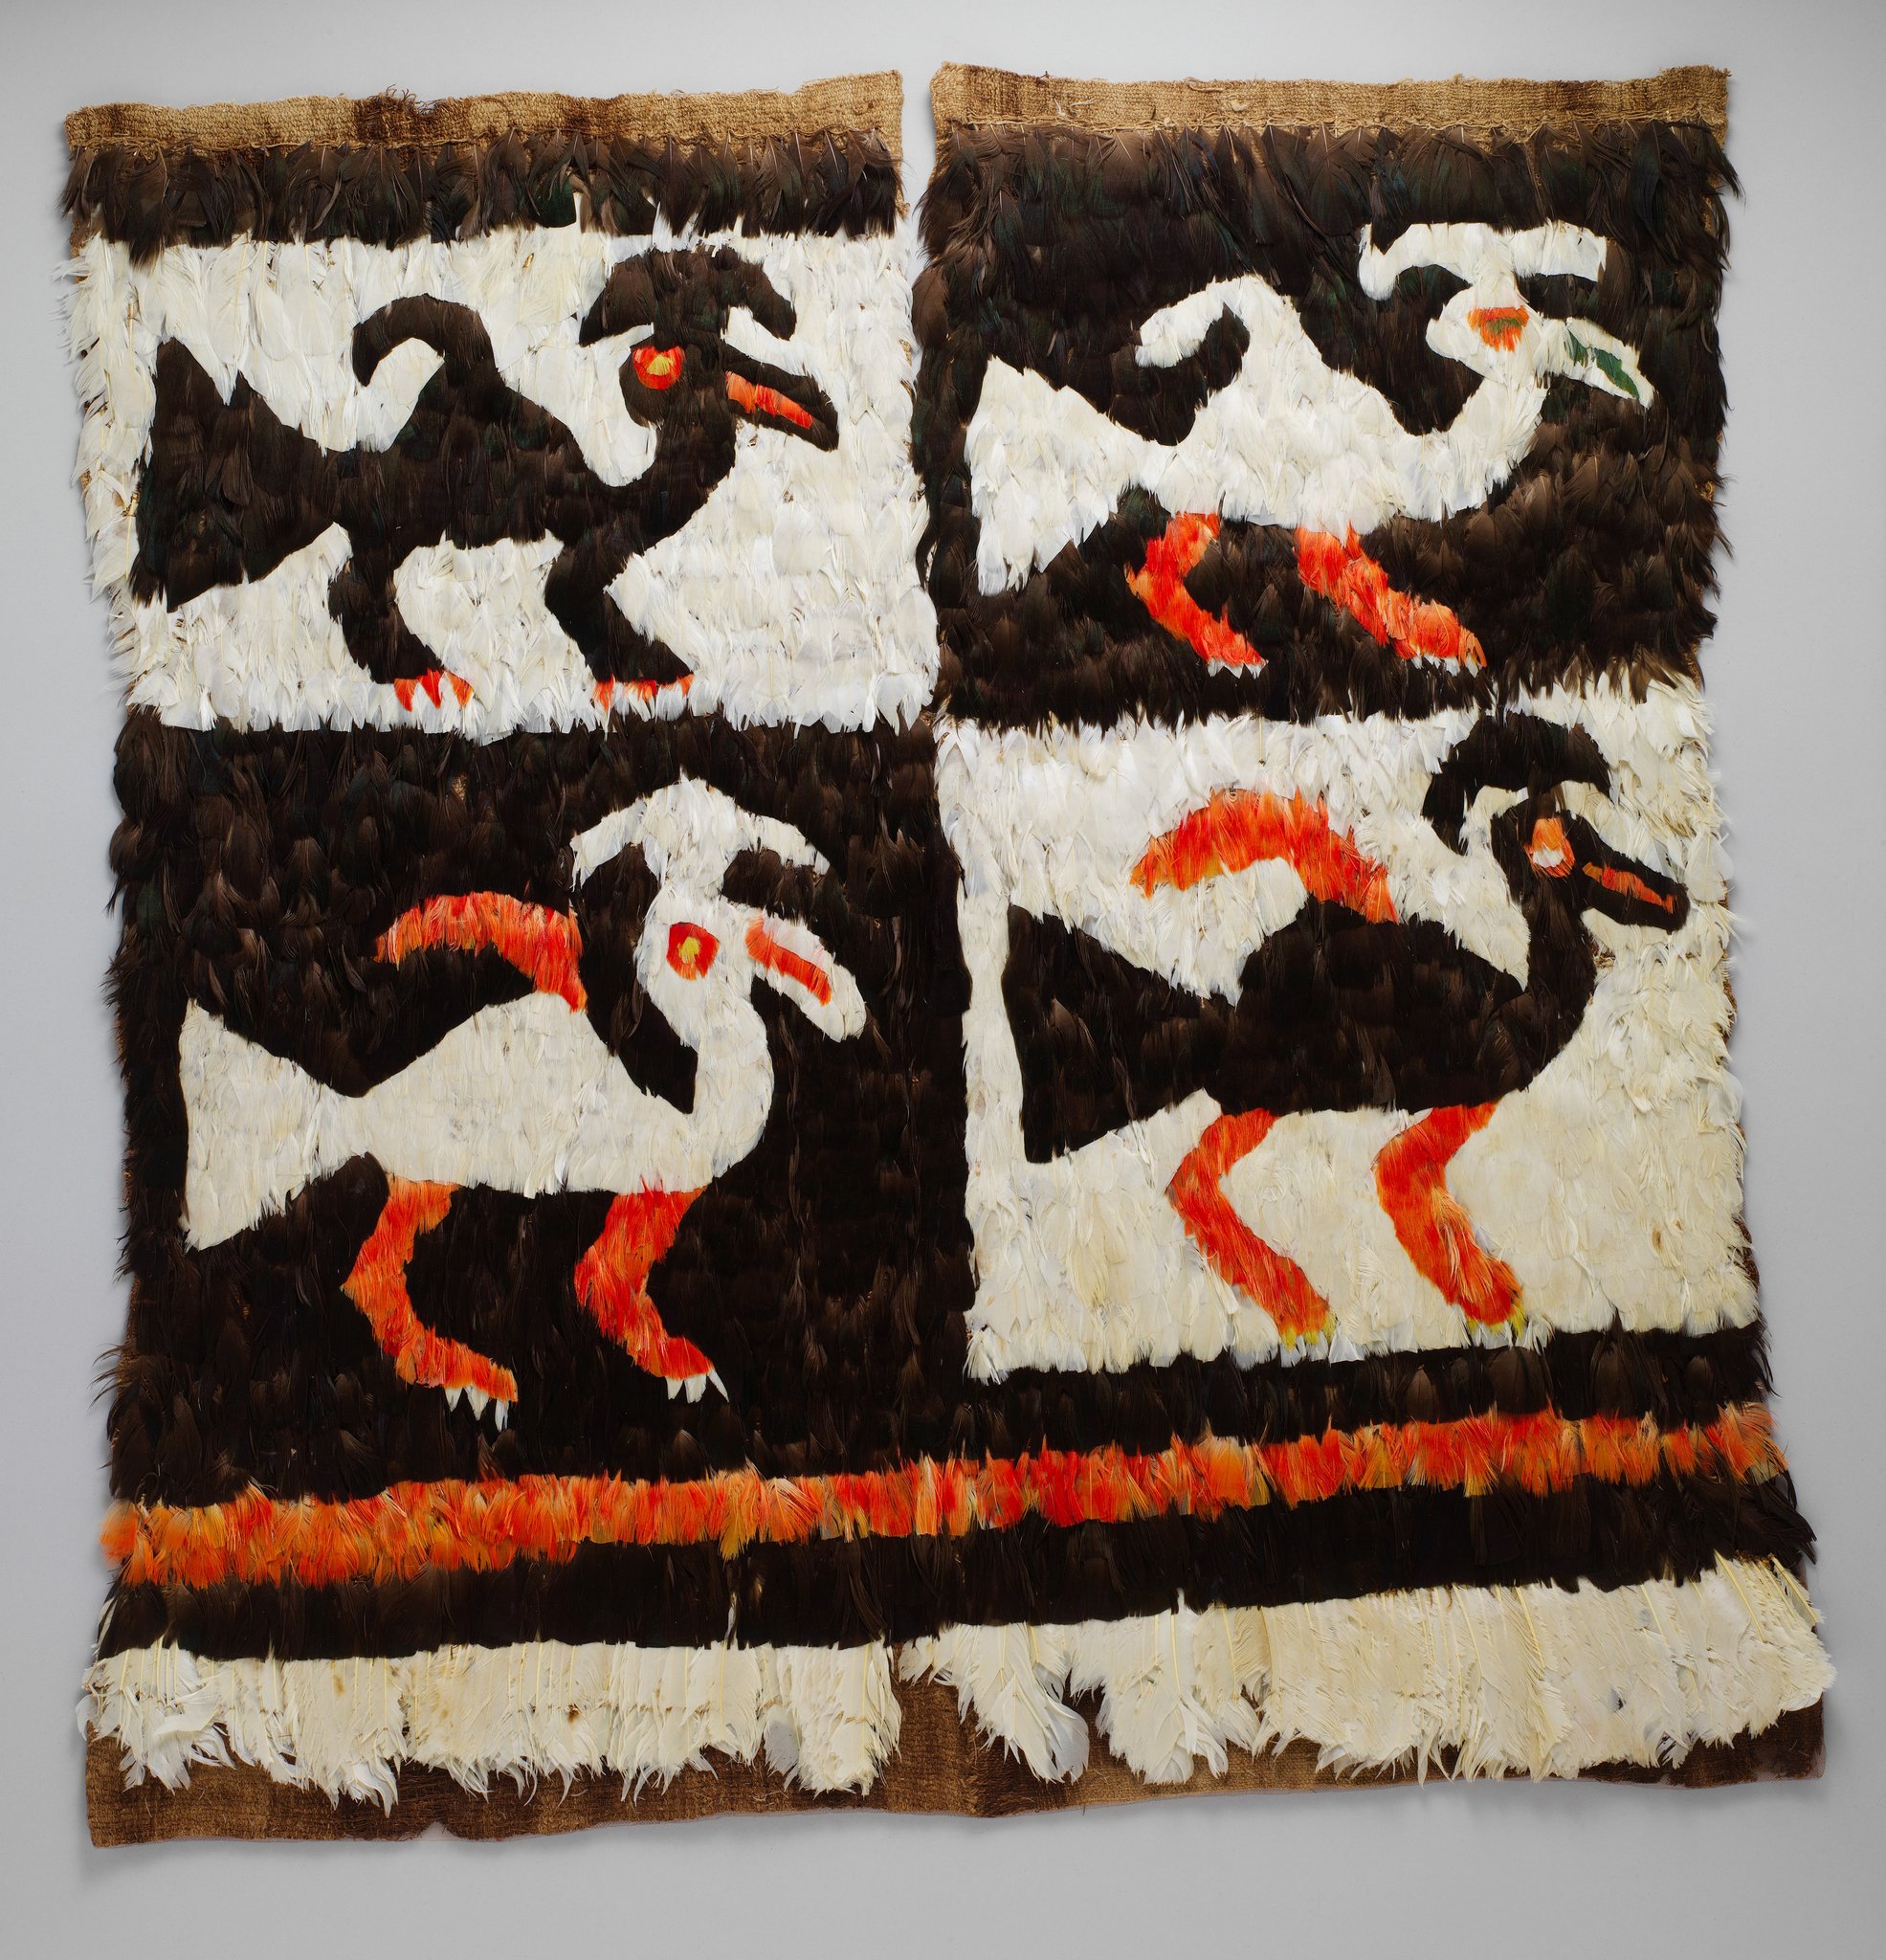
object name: tunic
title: Feathered Tunic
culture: chimú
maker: chimú artist(s)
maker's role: artist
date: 1400-1700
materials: cotton, feather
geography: peru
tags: birds